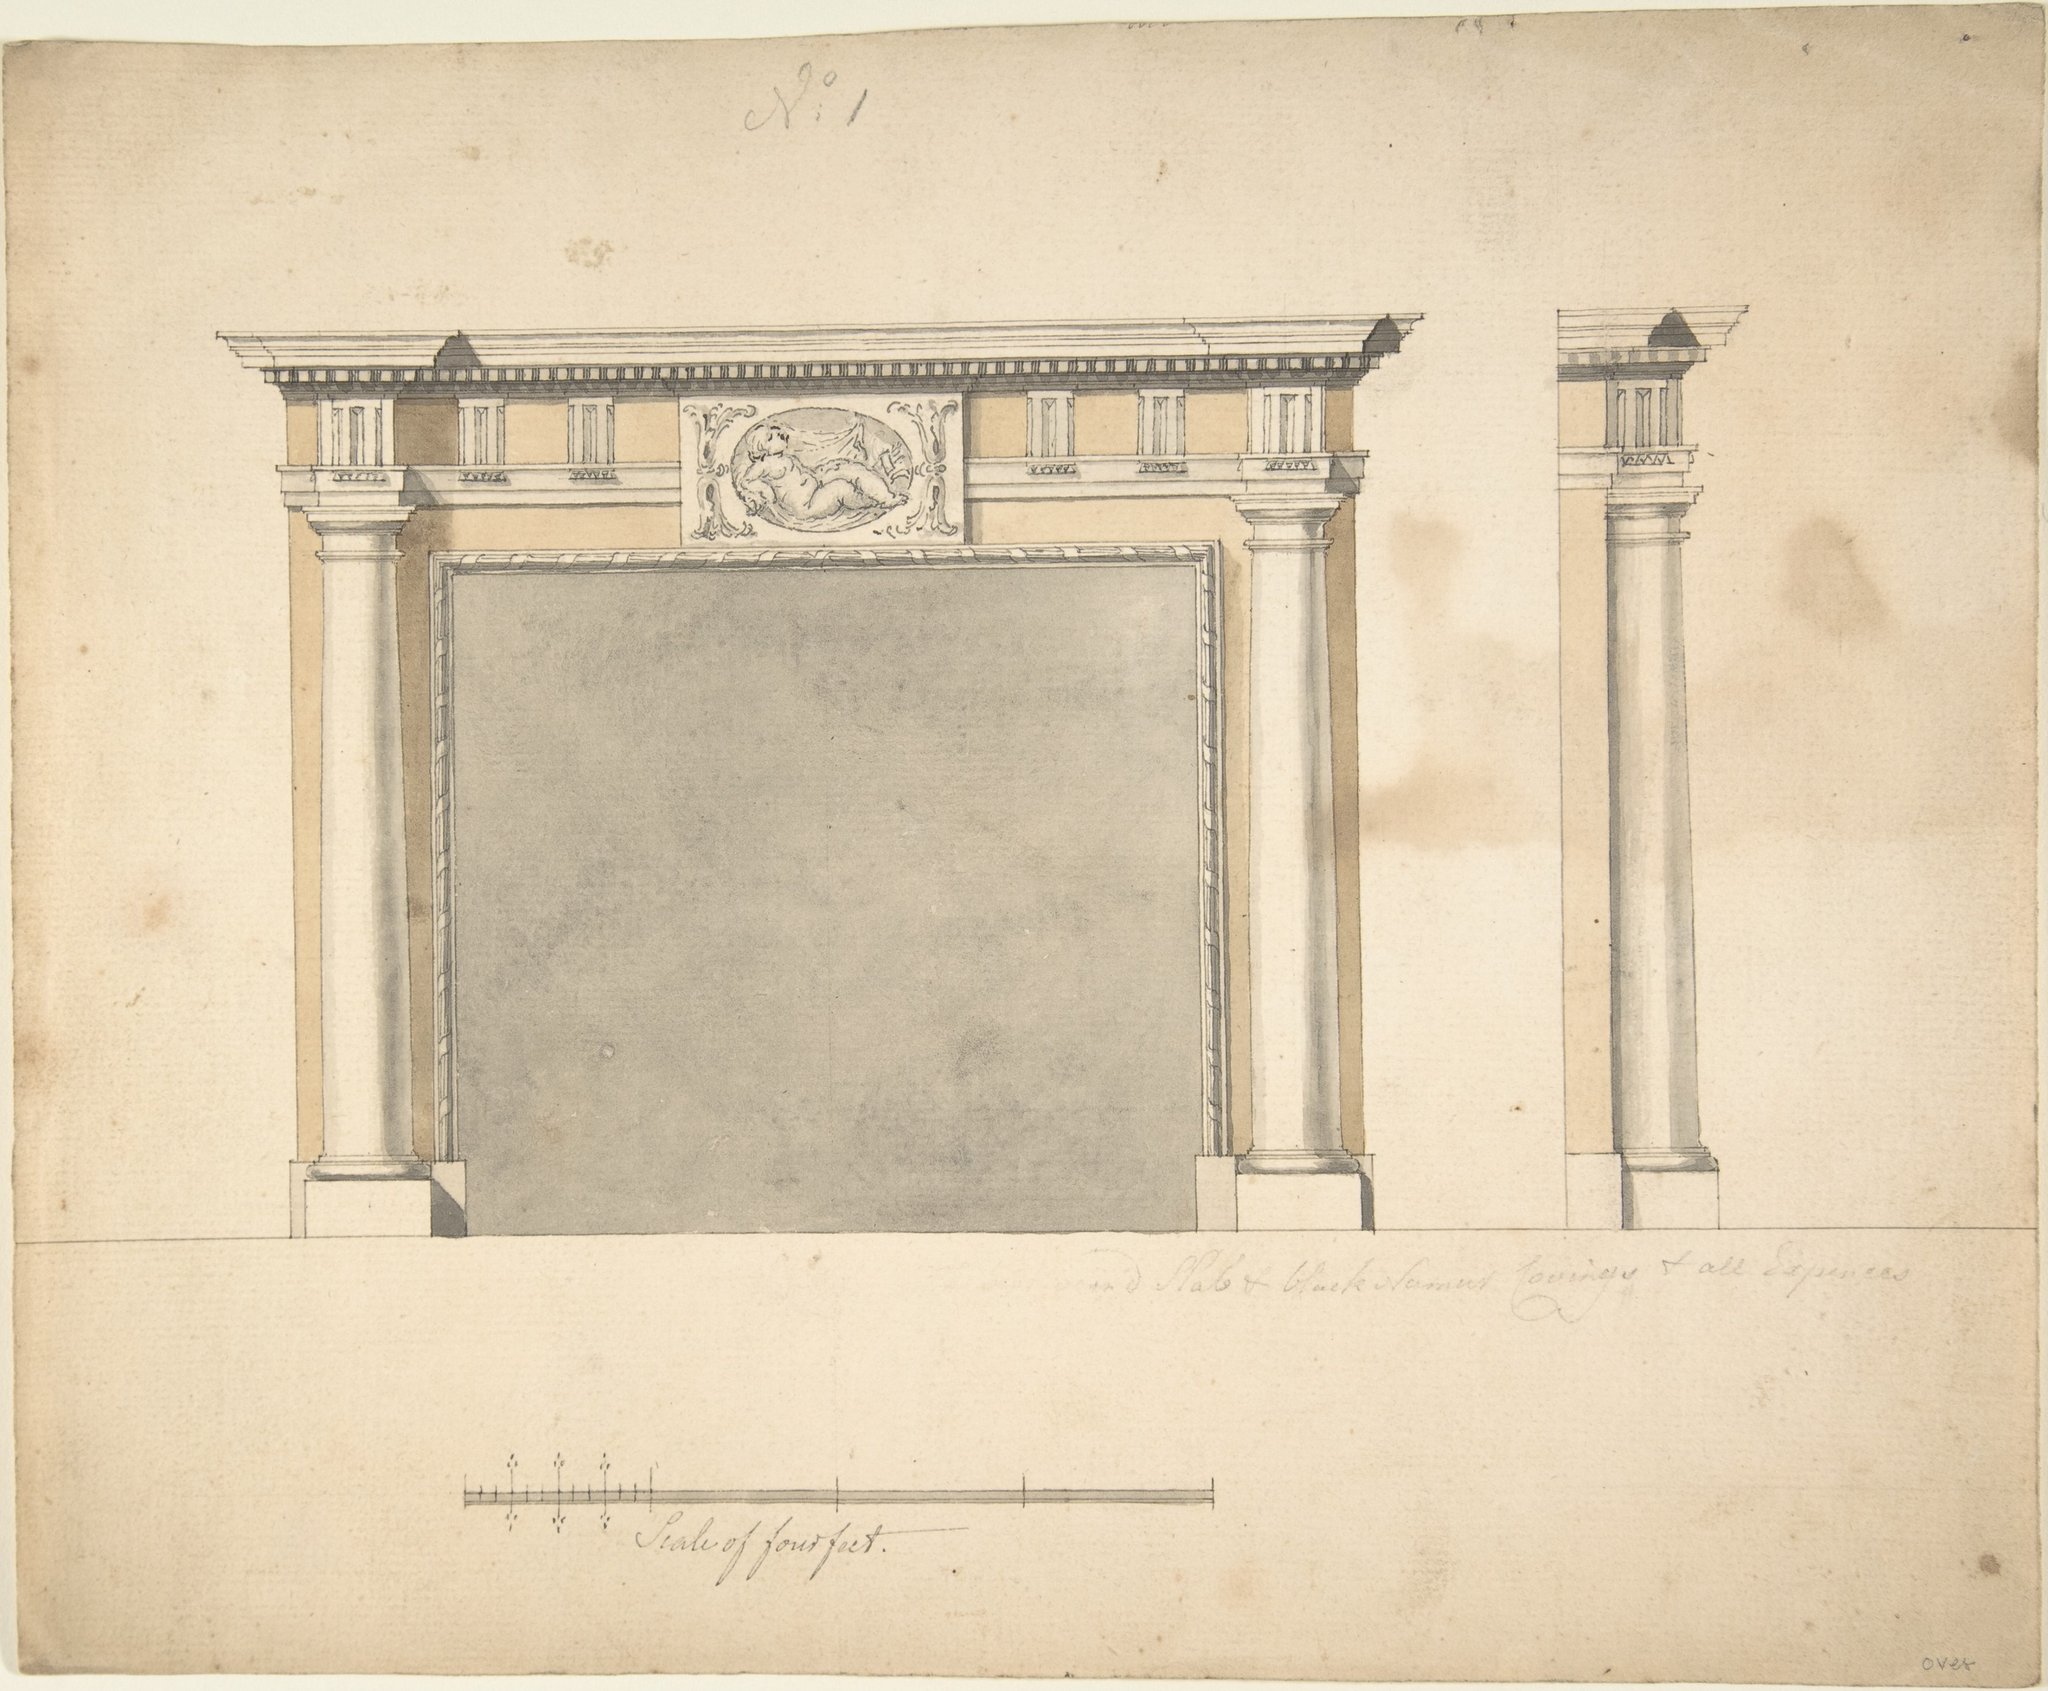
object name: drawing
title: Designs for a Chimney-piece for Richard Barwell's Drawing Room at Esher, Surrey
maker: sir william chambers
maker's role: artist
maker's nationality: british, born sweden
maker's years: 1723-1796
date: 1760-1769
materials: ink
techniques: brush, pen, wash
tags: architecture,fireplaces